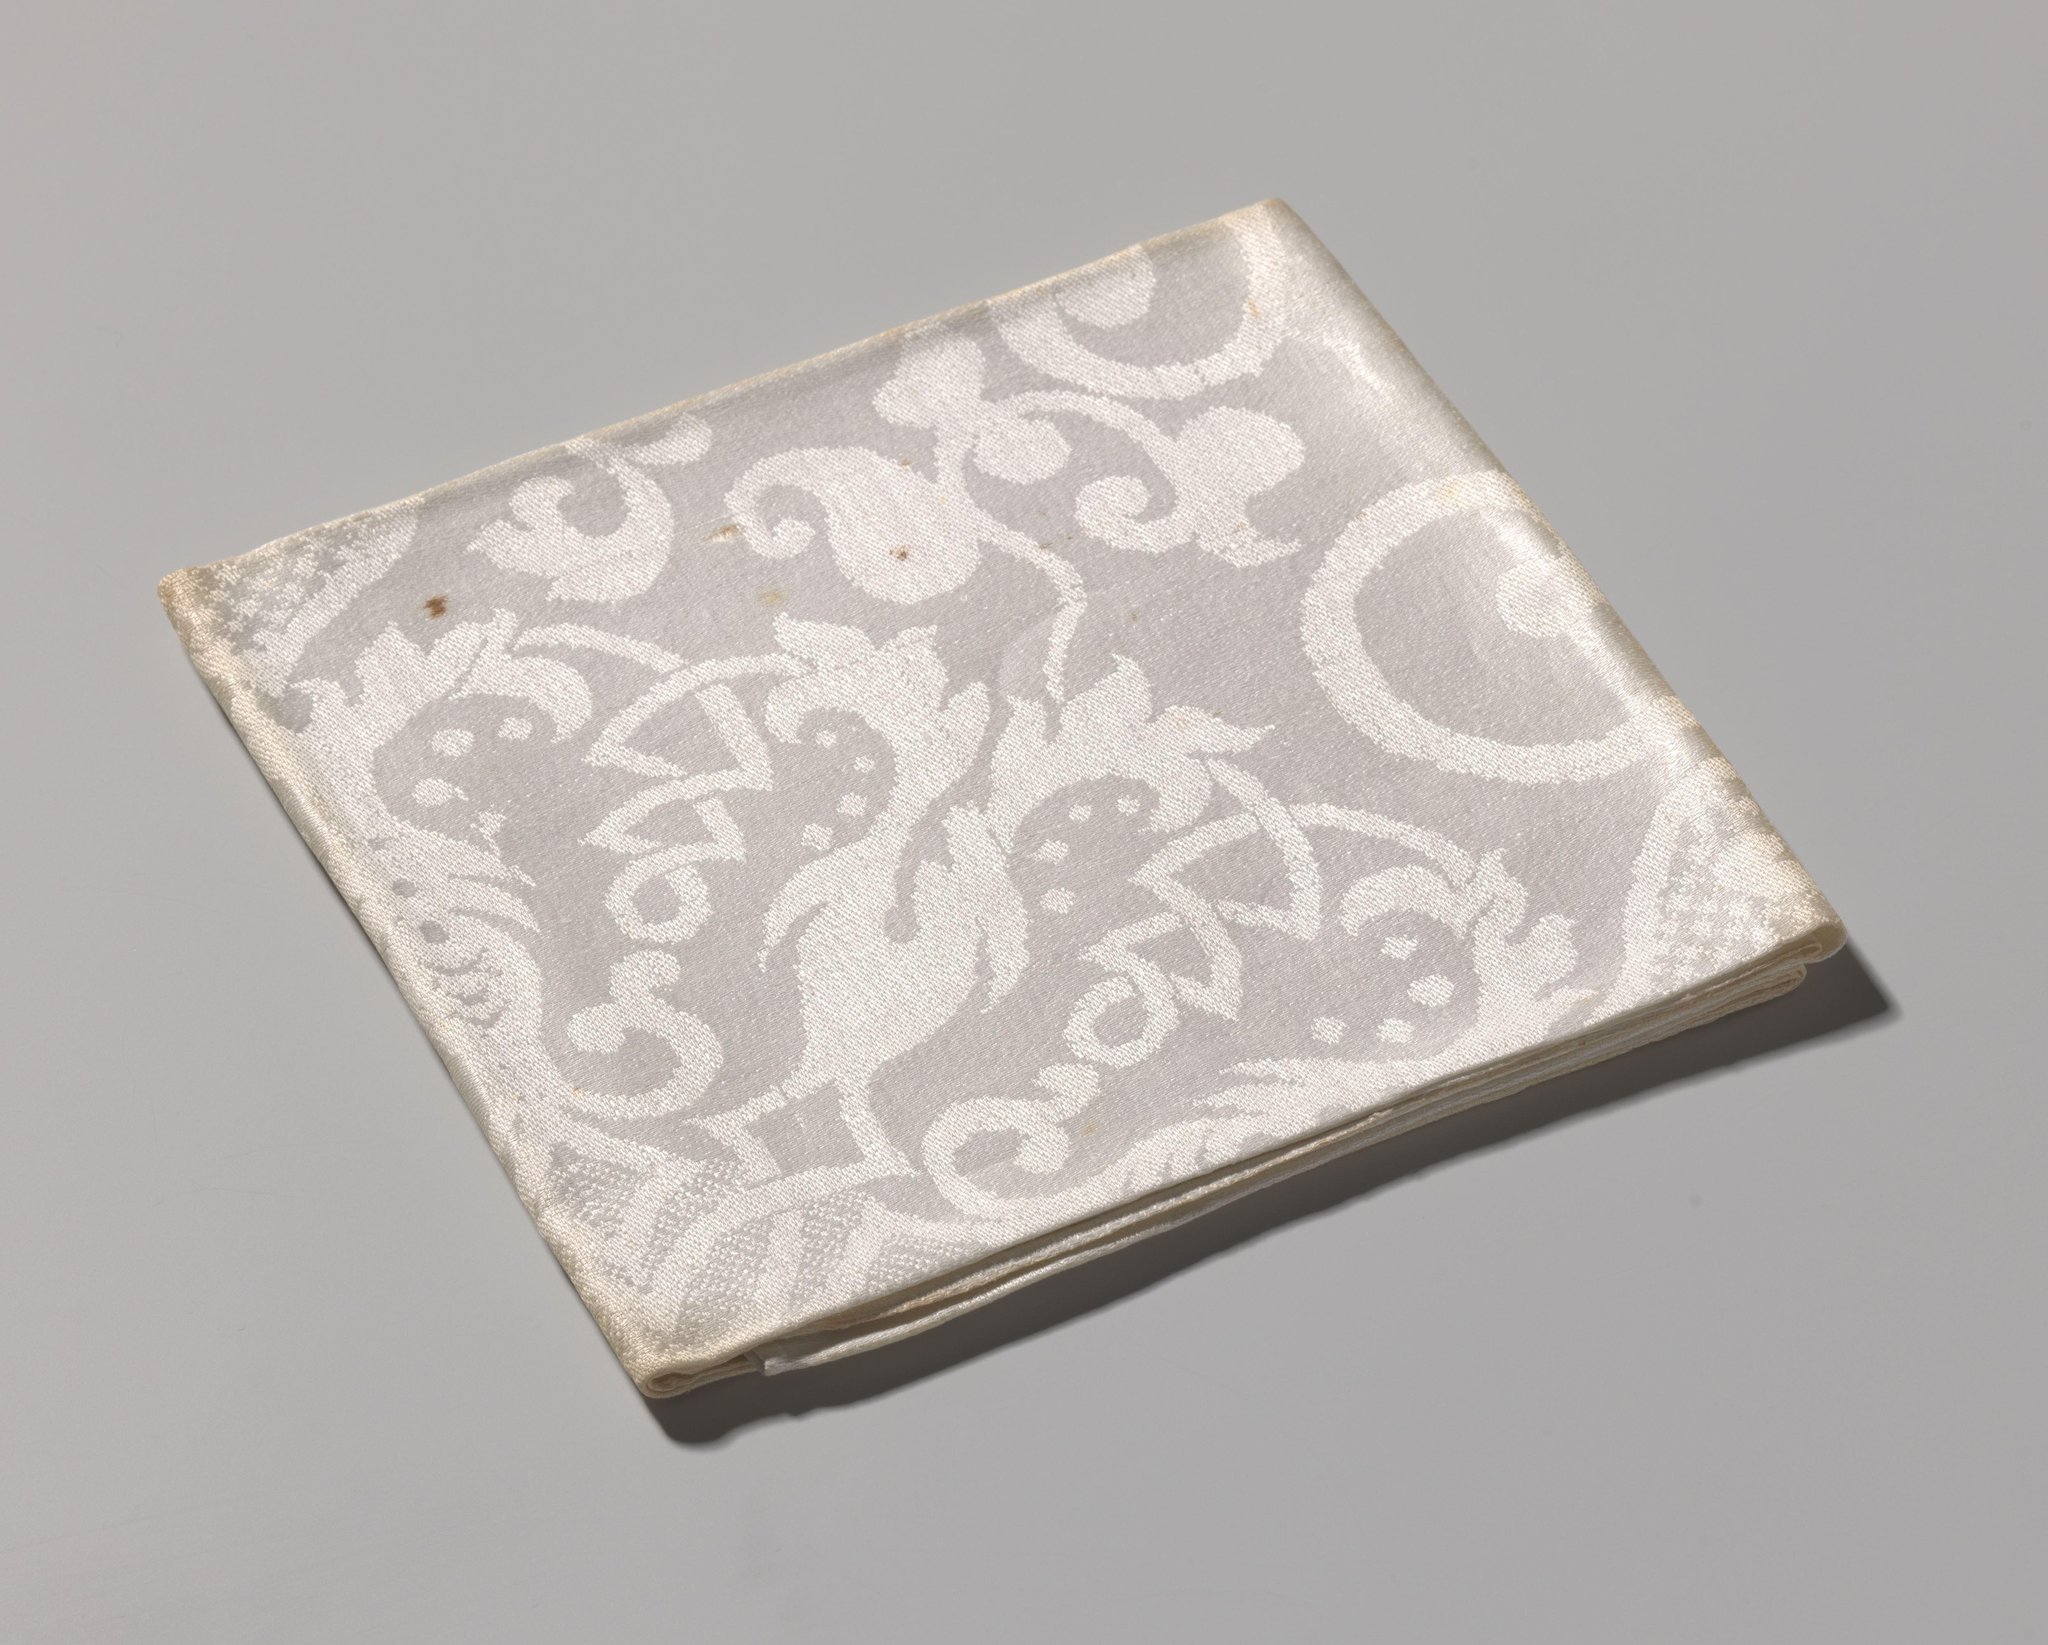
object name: napkin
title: Servet van wit linnendamast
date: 1890-1910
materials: linen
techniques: damask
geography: germany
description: Wit linnendamasten servet met een gestileerd bloempatroon, merk MB 24.